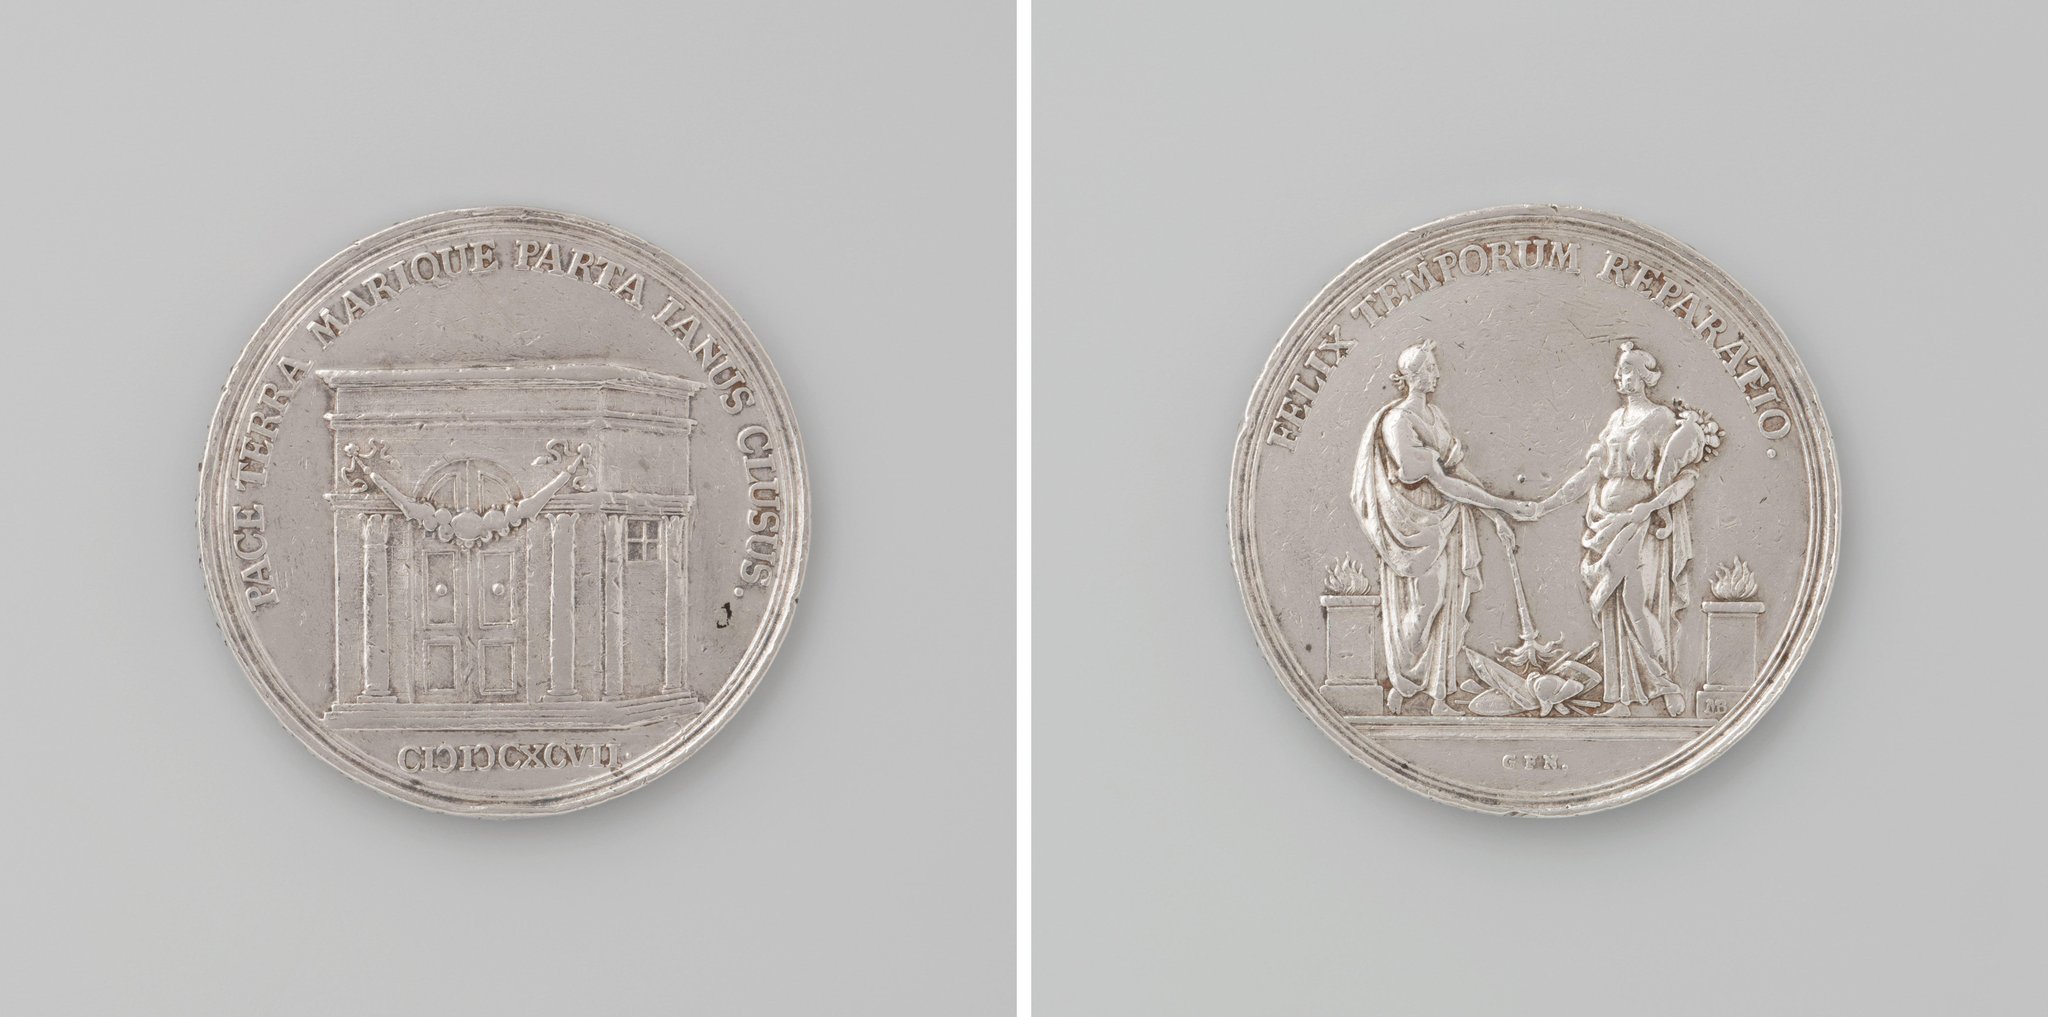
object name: history medal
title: Vrede van Rijswijk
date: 1697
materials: silver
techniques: striking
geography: nuremberg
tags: rijswijk, vrede van rijswijk (1697)